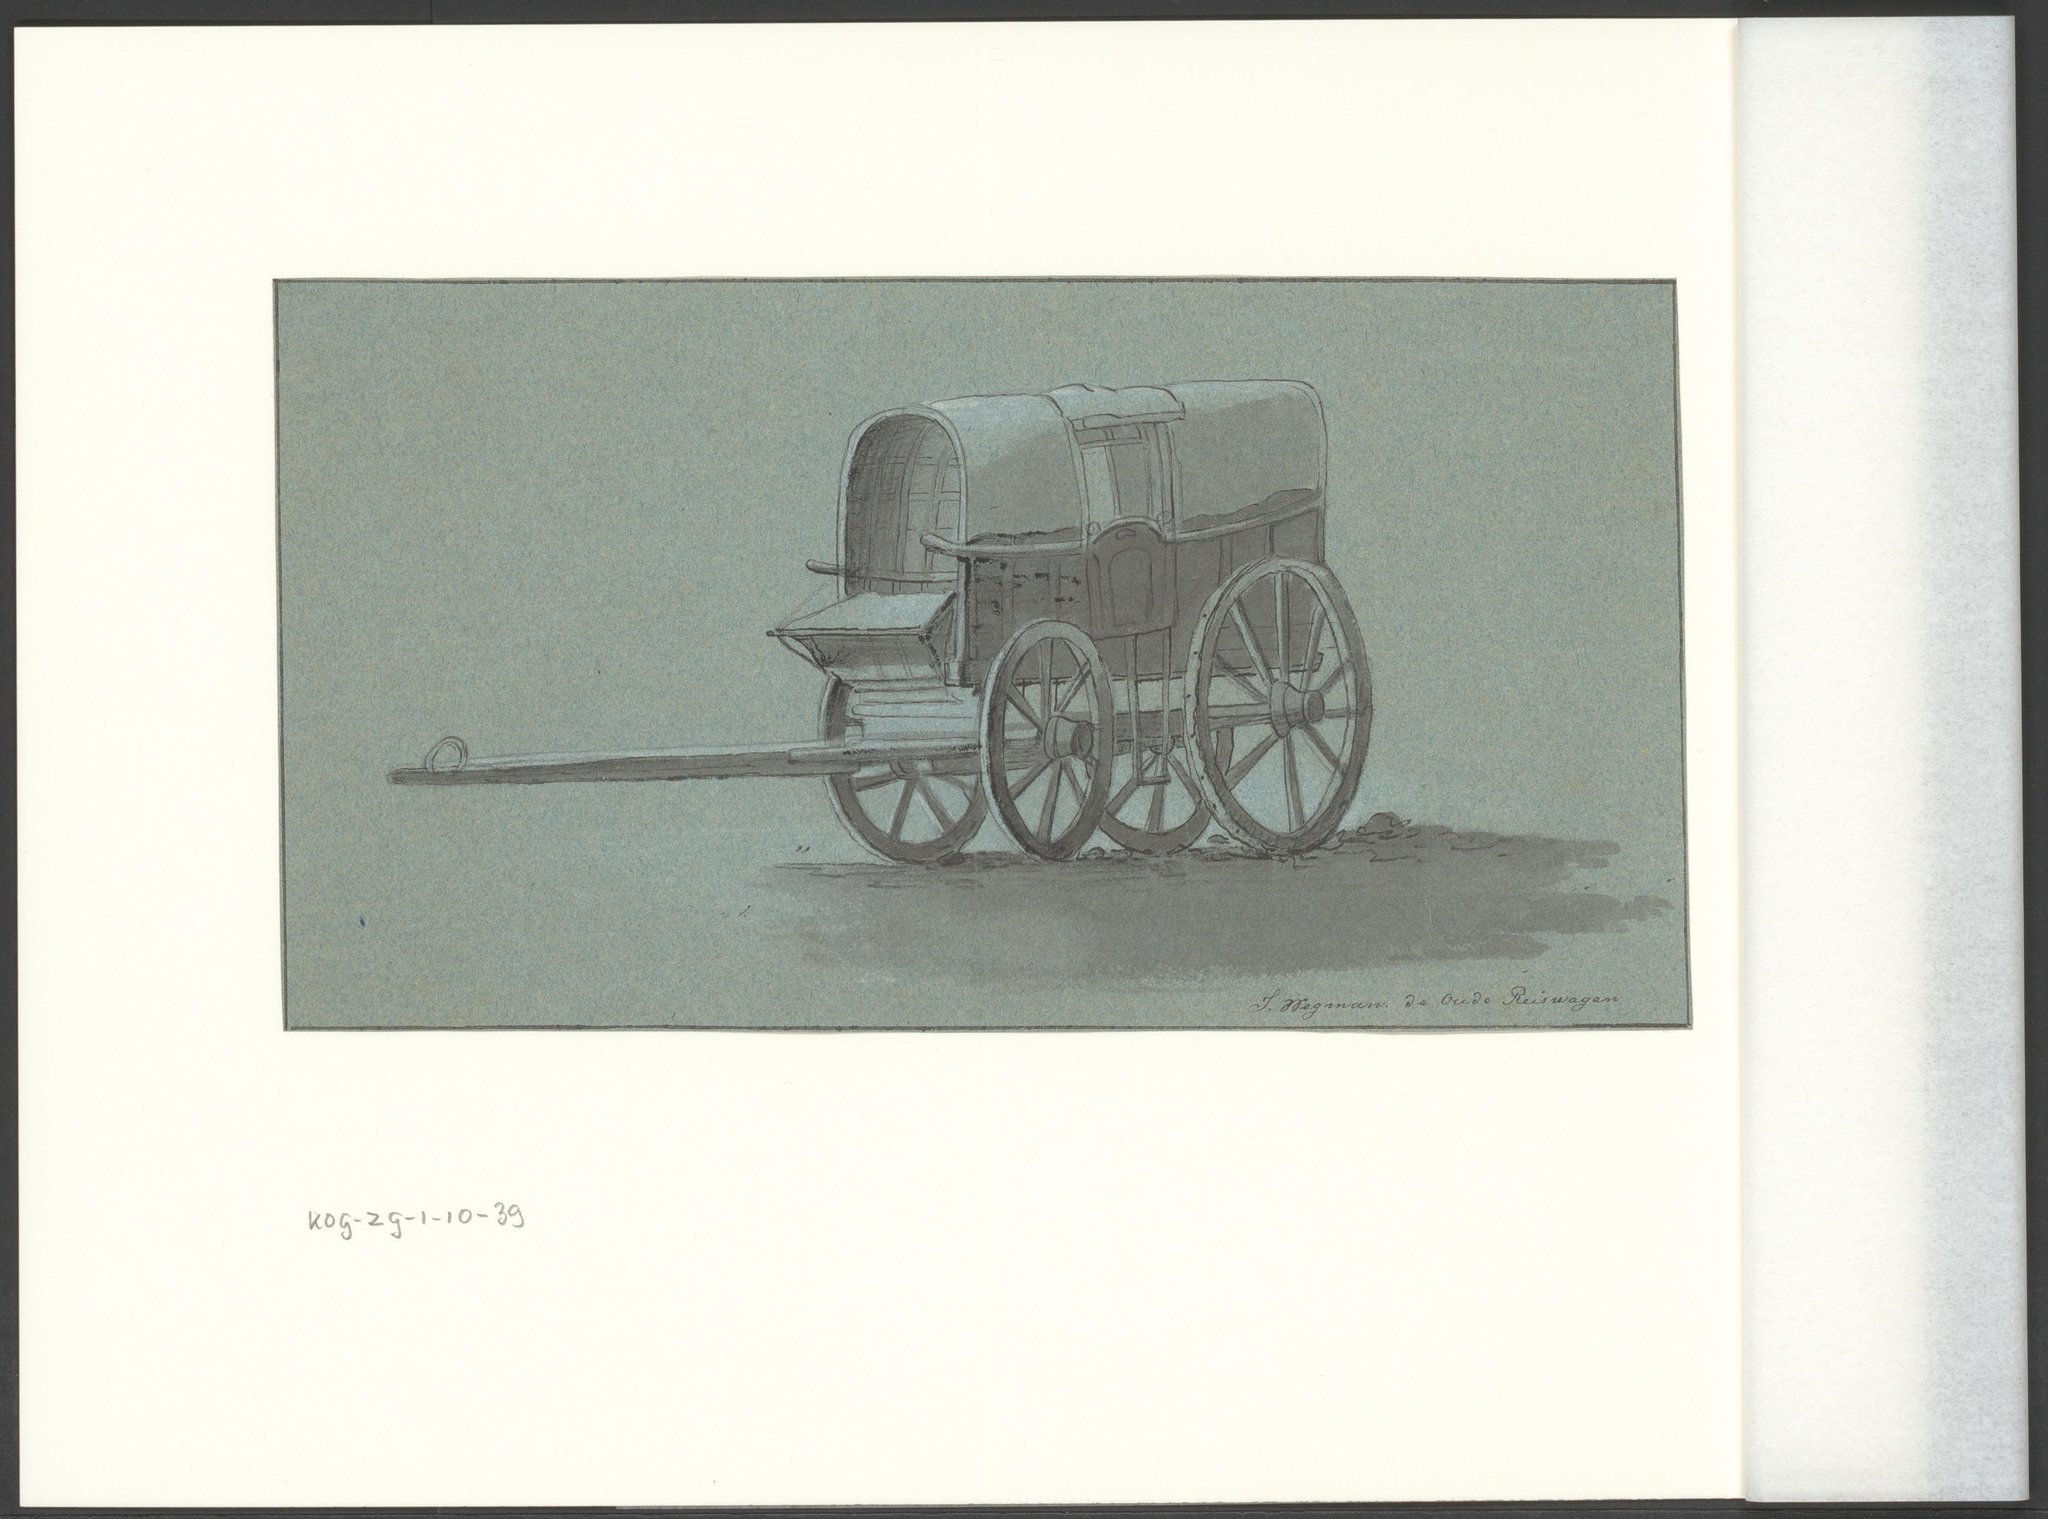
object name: drawing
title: De Oude Reiswagen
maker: j. wegman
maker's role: draughtsman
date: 1650-1749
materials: chalk, ink, paper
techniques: brush, pen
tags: four-wheeled, animal-drawn vehicle, e.g.: cab, carriage, coach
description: Onderwerpsrubrieken binnen de Atlas Zeden en Gewoonten: Vervoermiddelen te land en te water, Vervoermiddelen te land, Reiskoetsen en post.